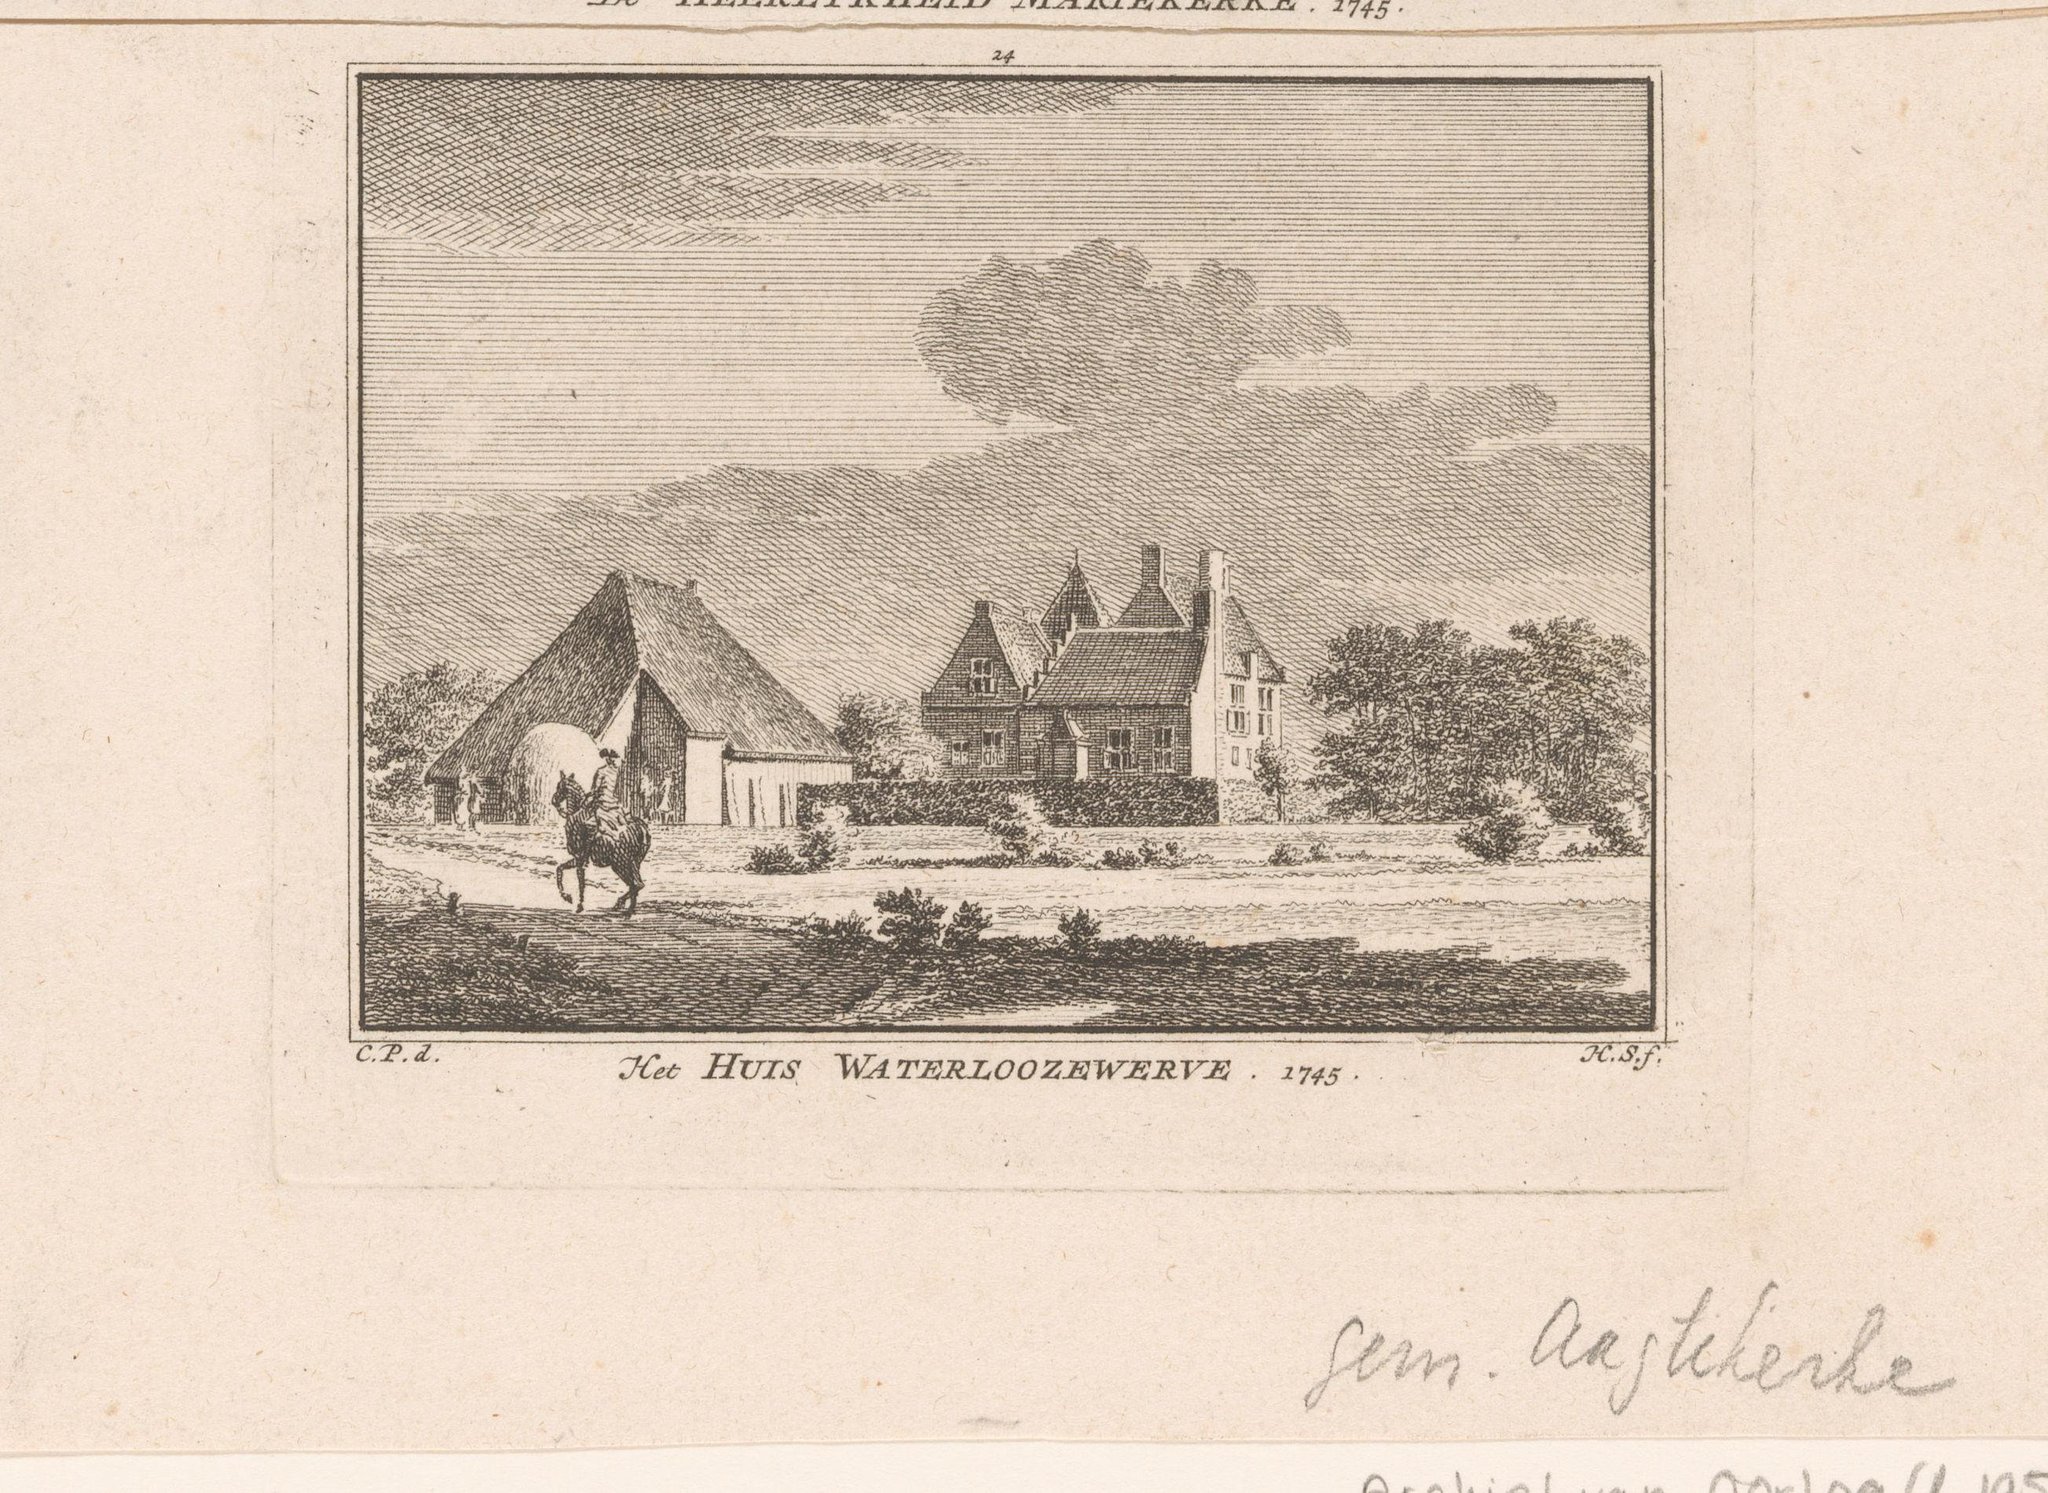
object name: print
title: Het Huis Waterloozewerve. 1745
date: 1754-1792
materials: paper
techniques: etching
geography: haarlem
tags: country-house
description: Prent ook gebruikt in: Het verheerlykt Nederland of kabinet van hedendaagsche gezigten van steden, dorpen (…). 9 delen. Amsterdam: Isaak Tirion en weduwe Isaak Tirion, 1745-1774, dl. 5 (1754), ill. 24. Of in: Nederlandsche tafereelen; of eene keurige verzameling van negen honderd fraaije gezigten van steden, dorpen, sloten, oudheden [….]. 9 delen. Amsterdam: Jan de Groot, 1792, dl. 5, ill. 24.